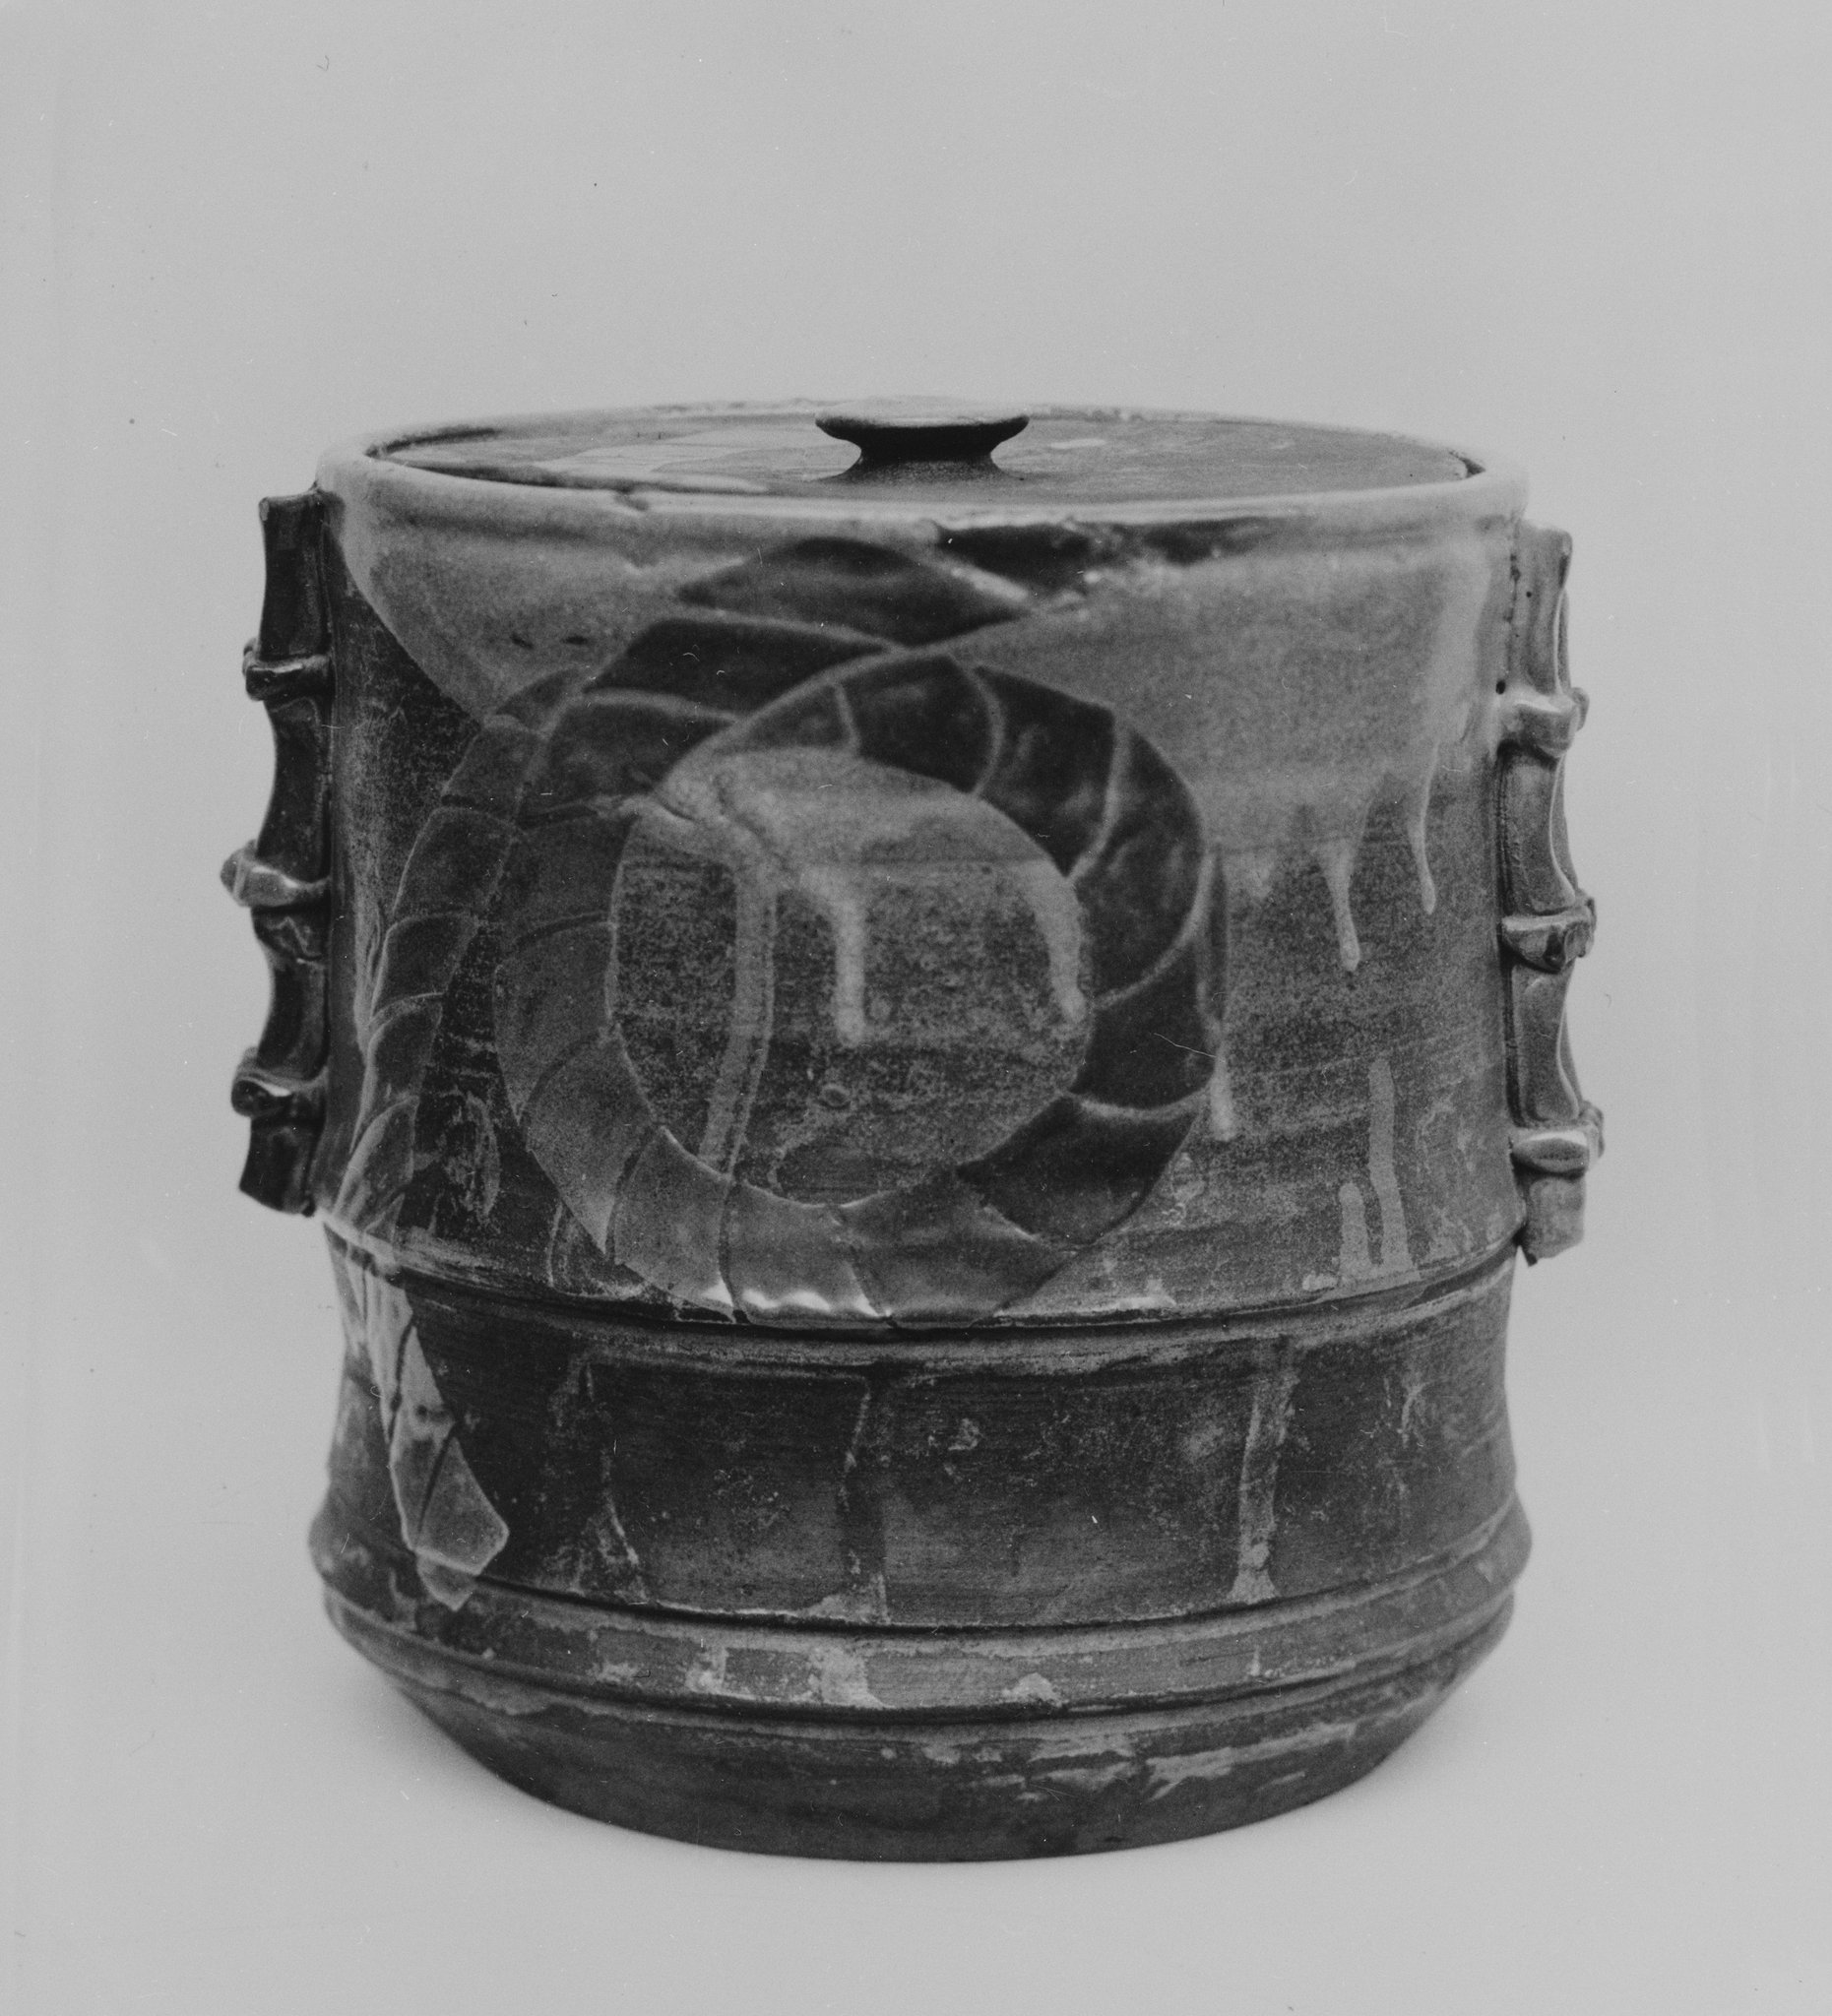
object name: jar with cover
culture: japanese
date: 1820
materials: enamel, faience, glaze